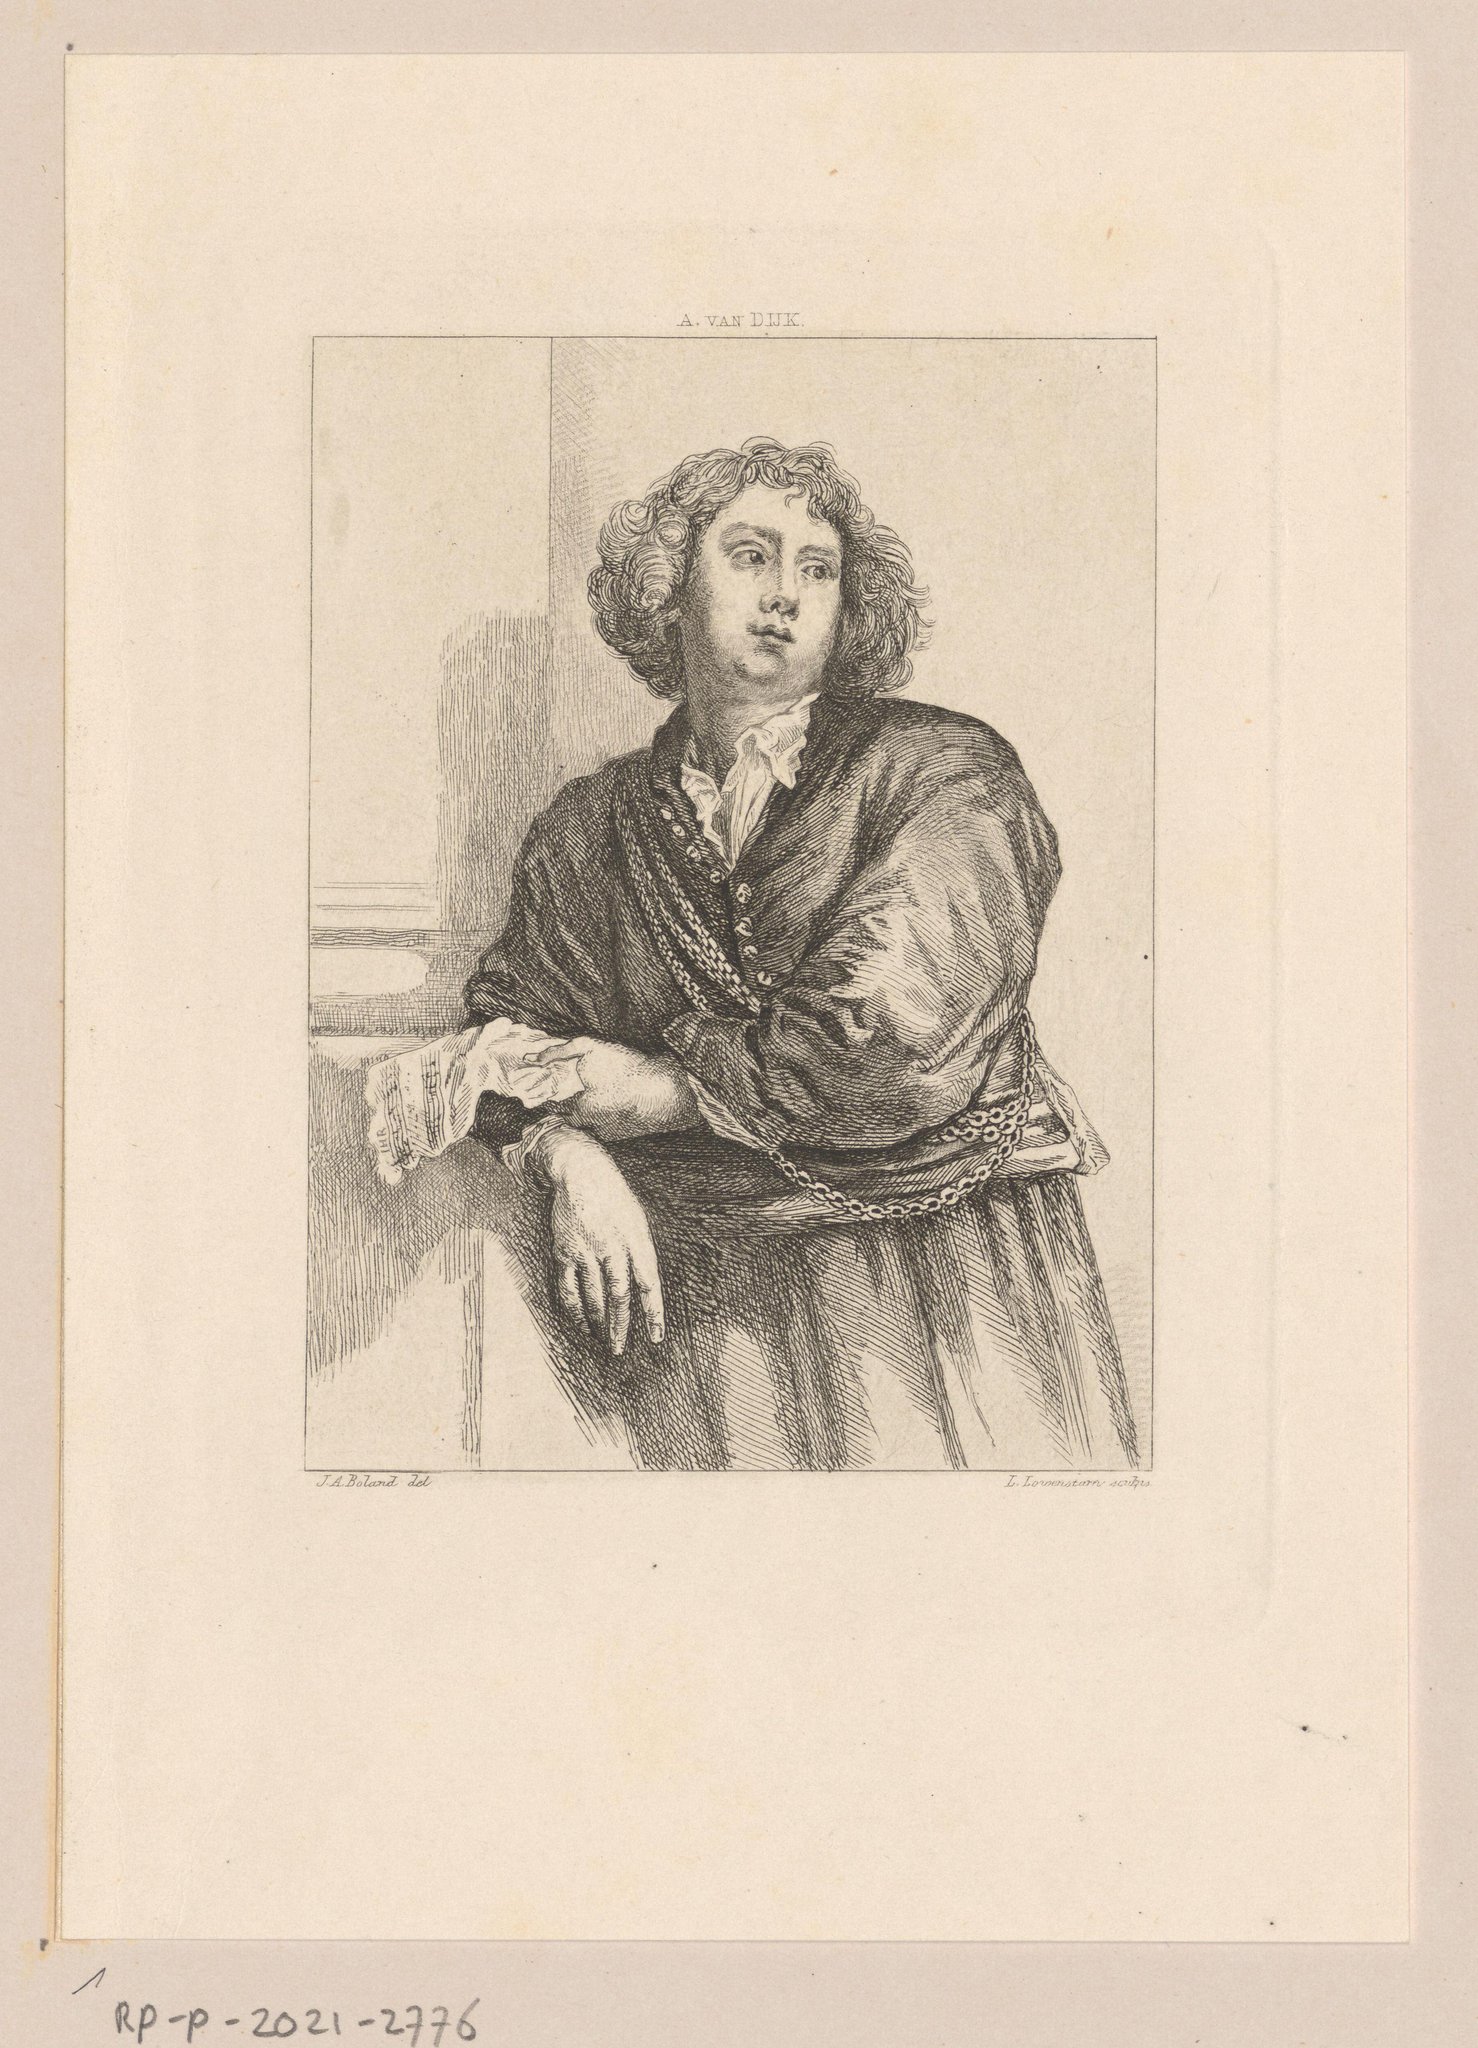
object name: print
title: Portret van Hernicus Liberti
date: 1852-1898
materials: paper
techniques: etching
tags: notation of music, historical persons, portrait of composer